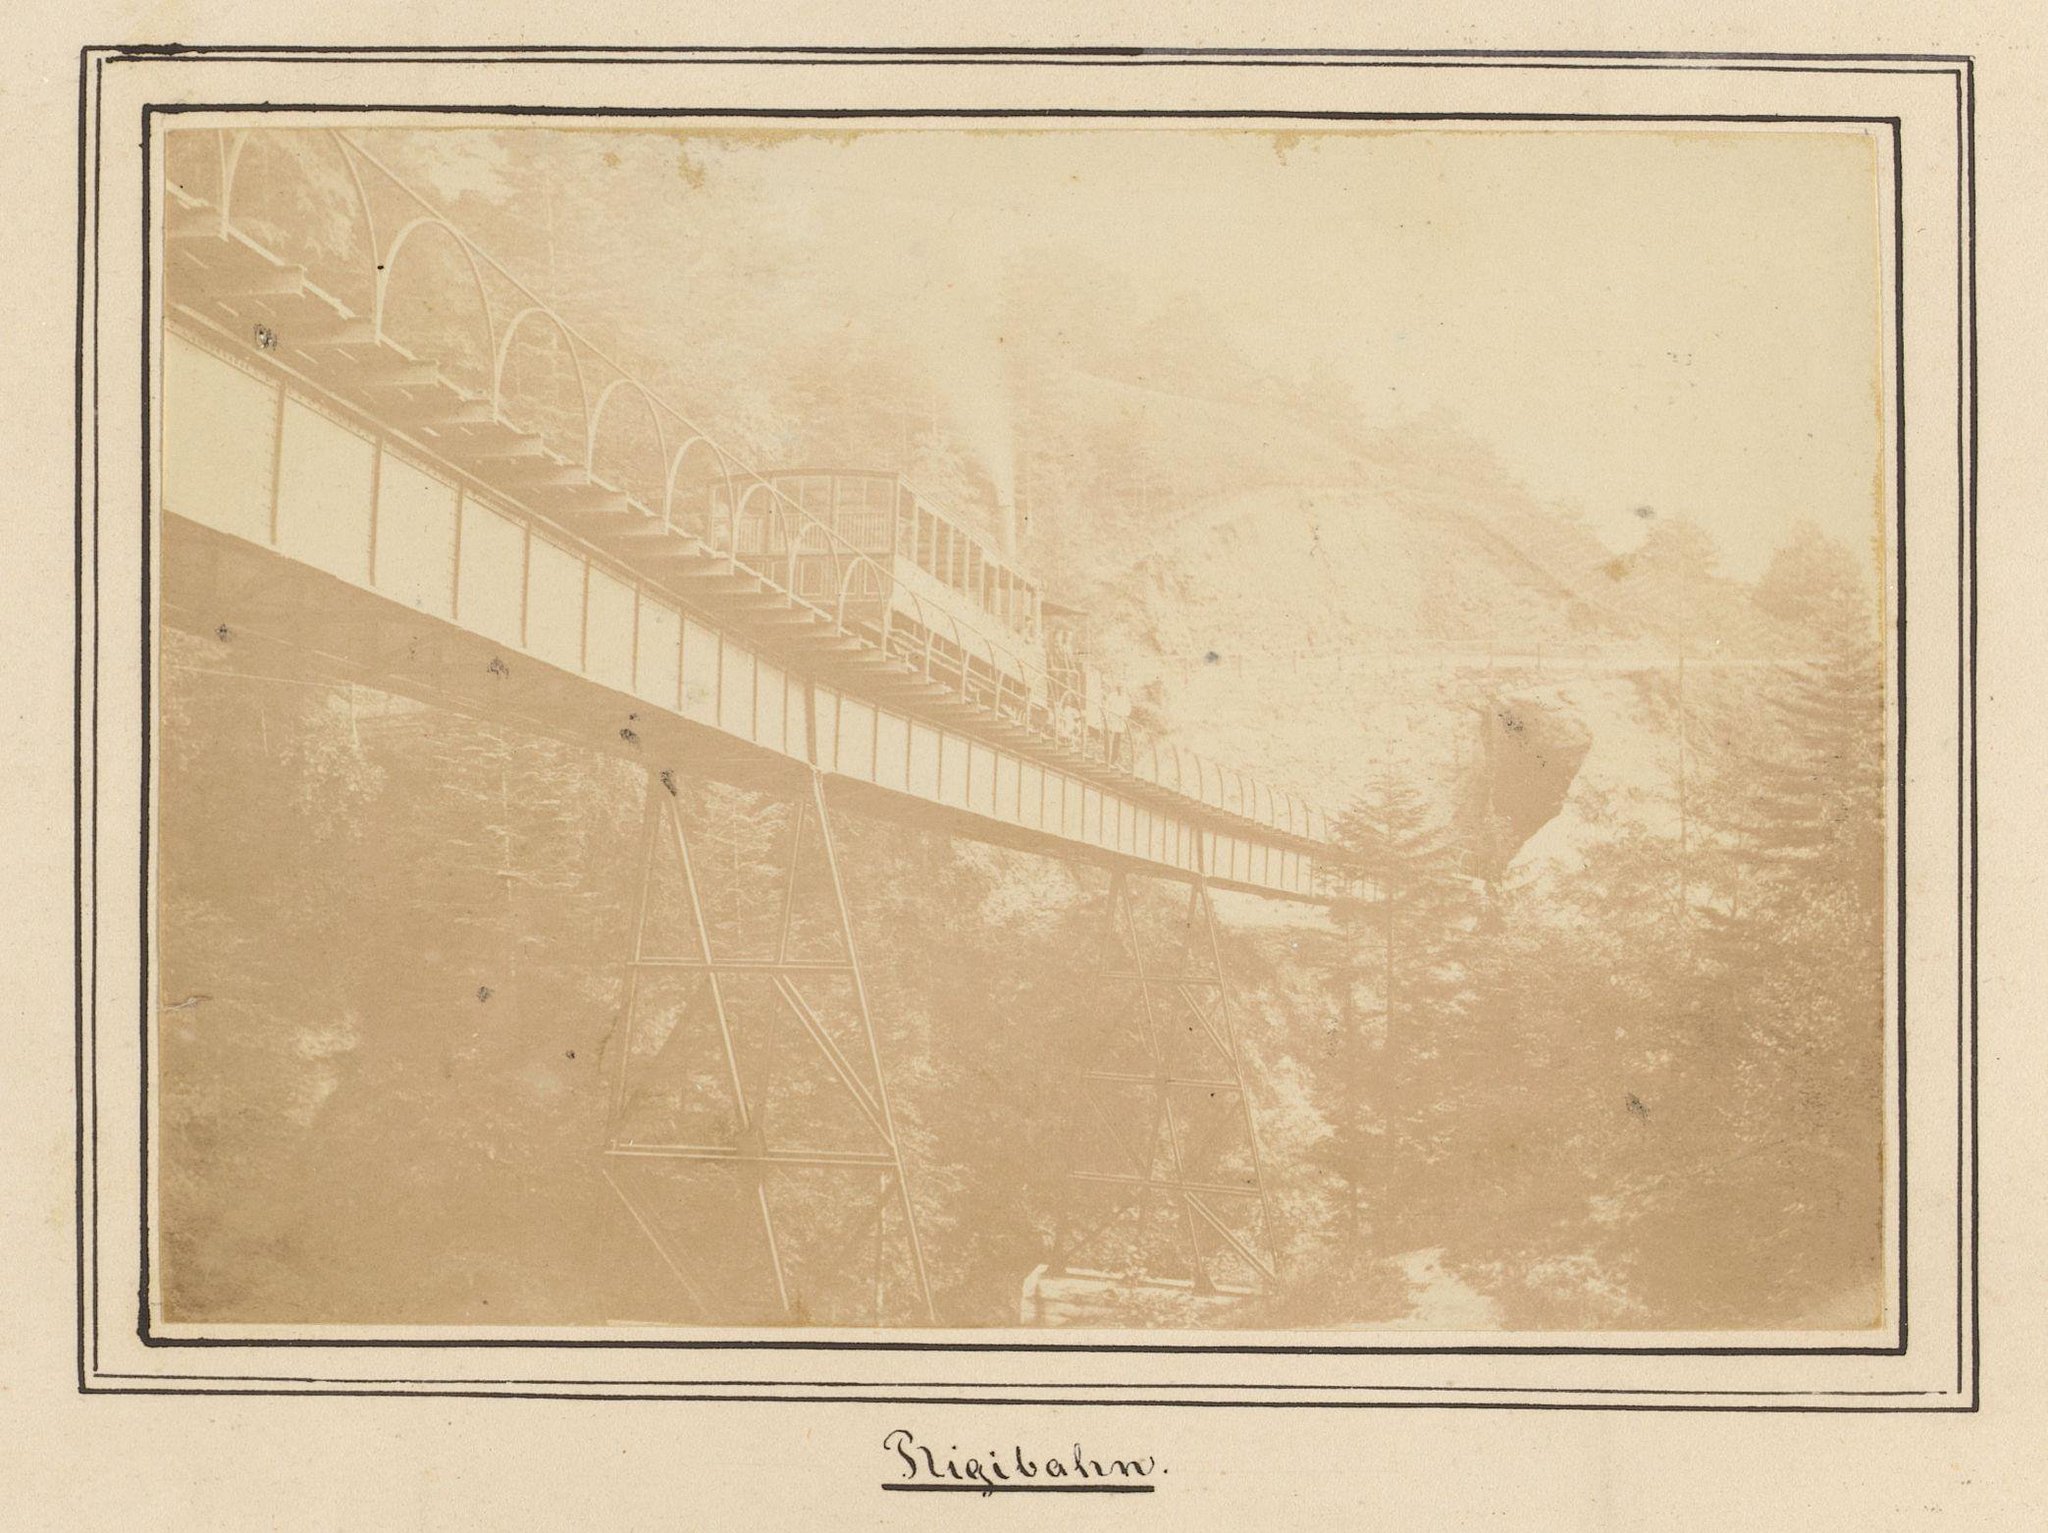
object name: album leaf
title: Trein rijdt over de spoorlijn Vitznau-Rigi Kulm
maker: Anonymous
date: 1871-1890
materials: paper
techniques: albumen print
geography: vitznau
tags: passenger train, bridge